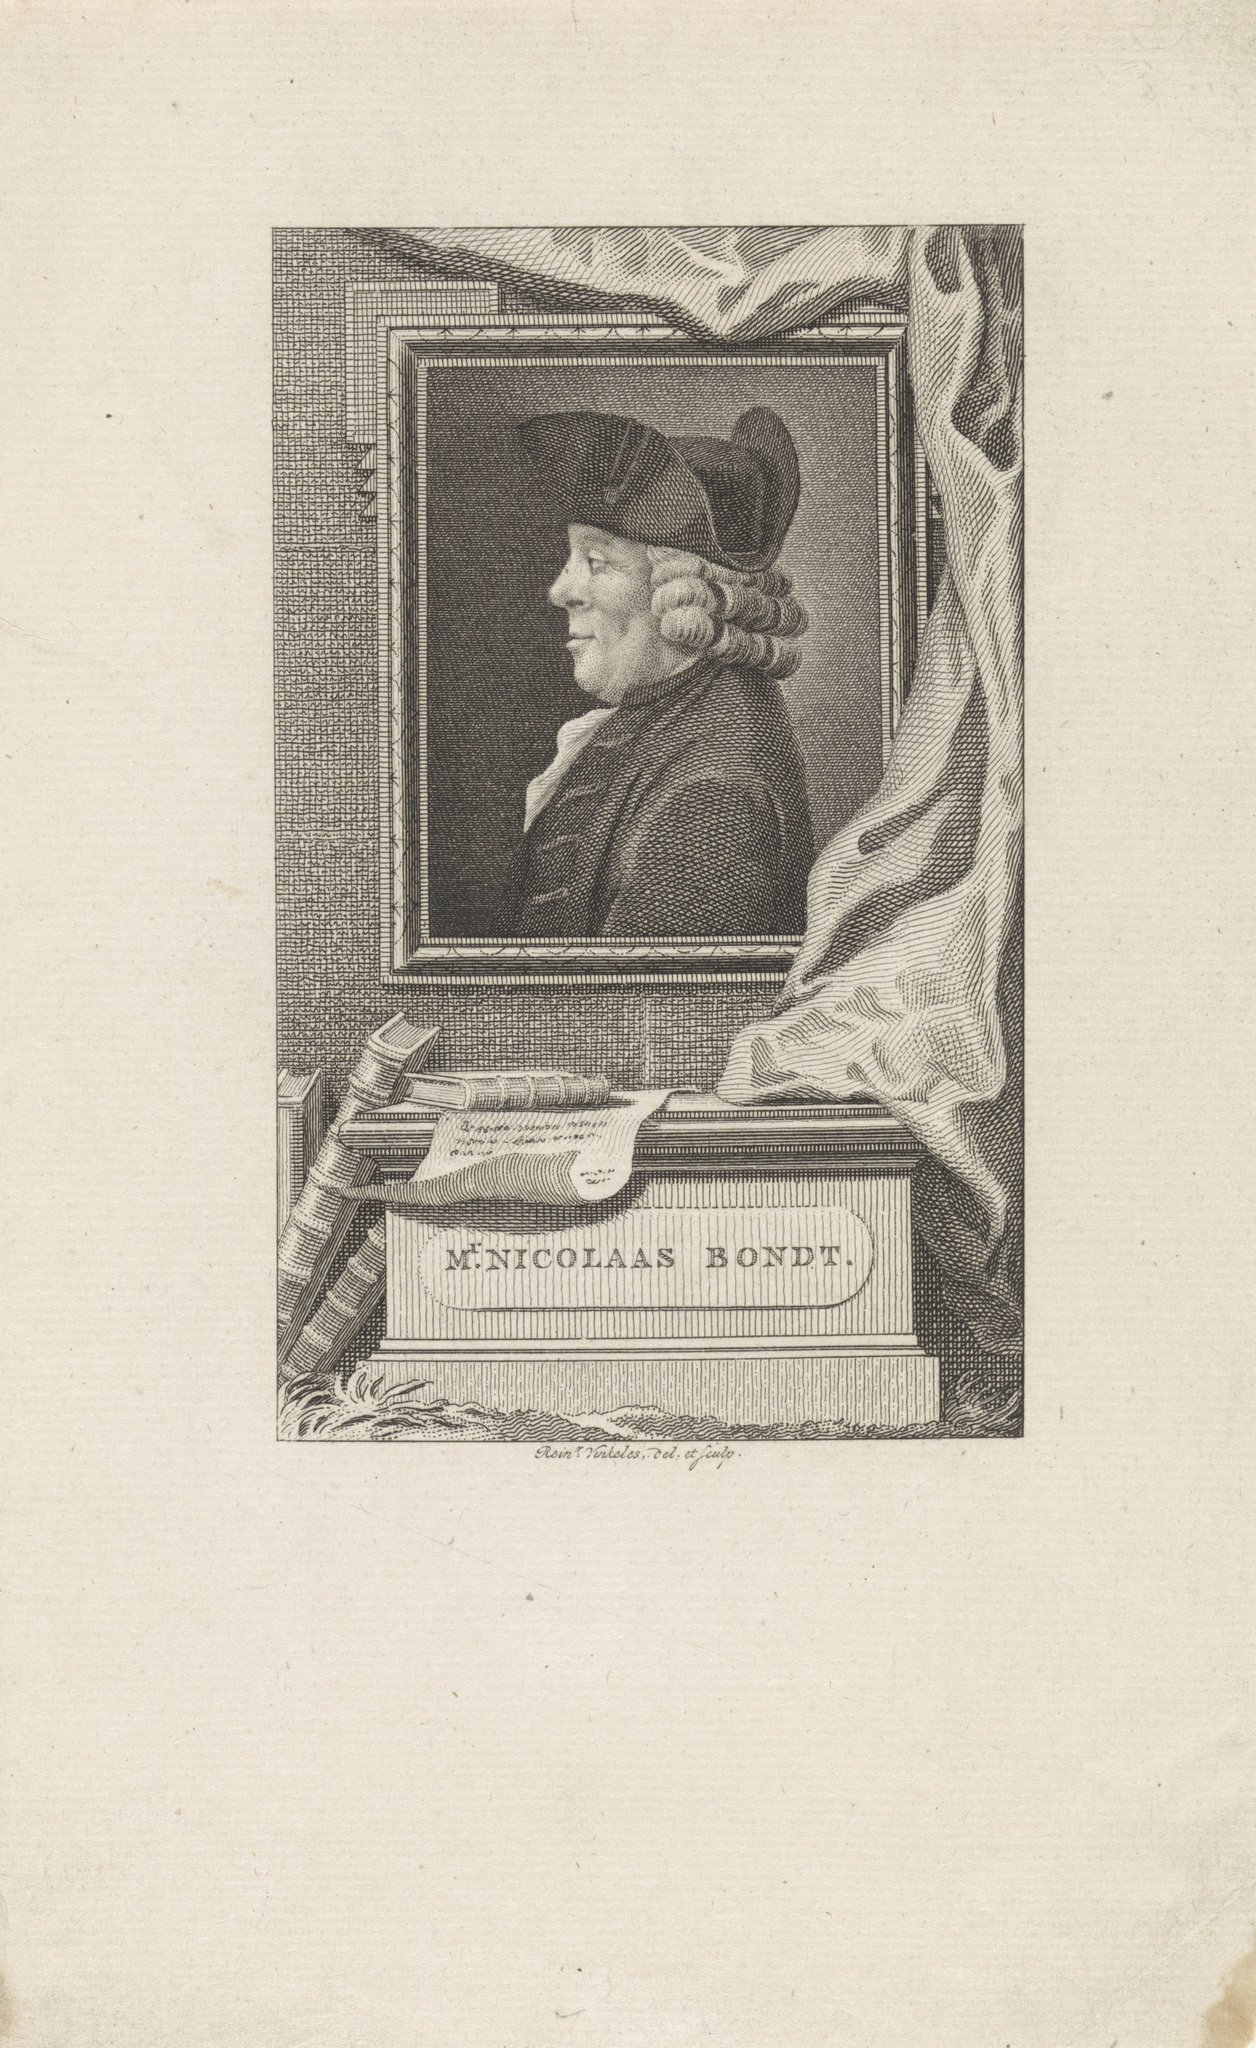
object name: print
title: Portret van Nicolaas Bondt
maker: reinier vinkeles (i)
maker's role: draughtsman, print maker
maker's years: 1741-1816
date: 1786-1809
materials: paper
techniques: engraving, etching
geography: amsterdam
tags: amsterdam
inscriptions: collector's mark: Lugt 2228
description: Prent ook gebruikt als boekillustratie in: Wagenaar, Jan. Vaderlandsche historie, (...) ten vervolge van Wagenaars Vaderlandsche historie. Dl. 1-43. Amsterdam: Johannes Allart, 1786-1809.